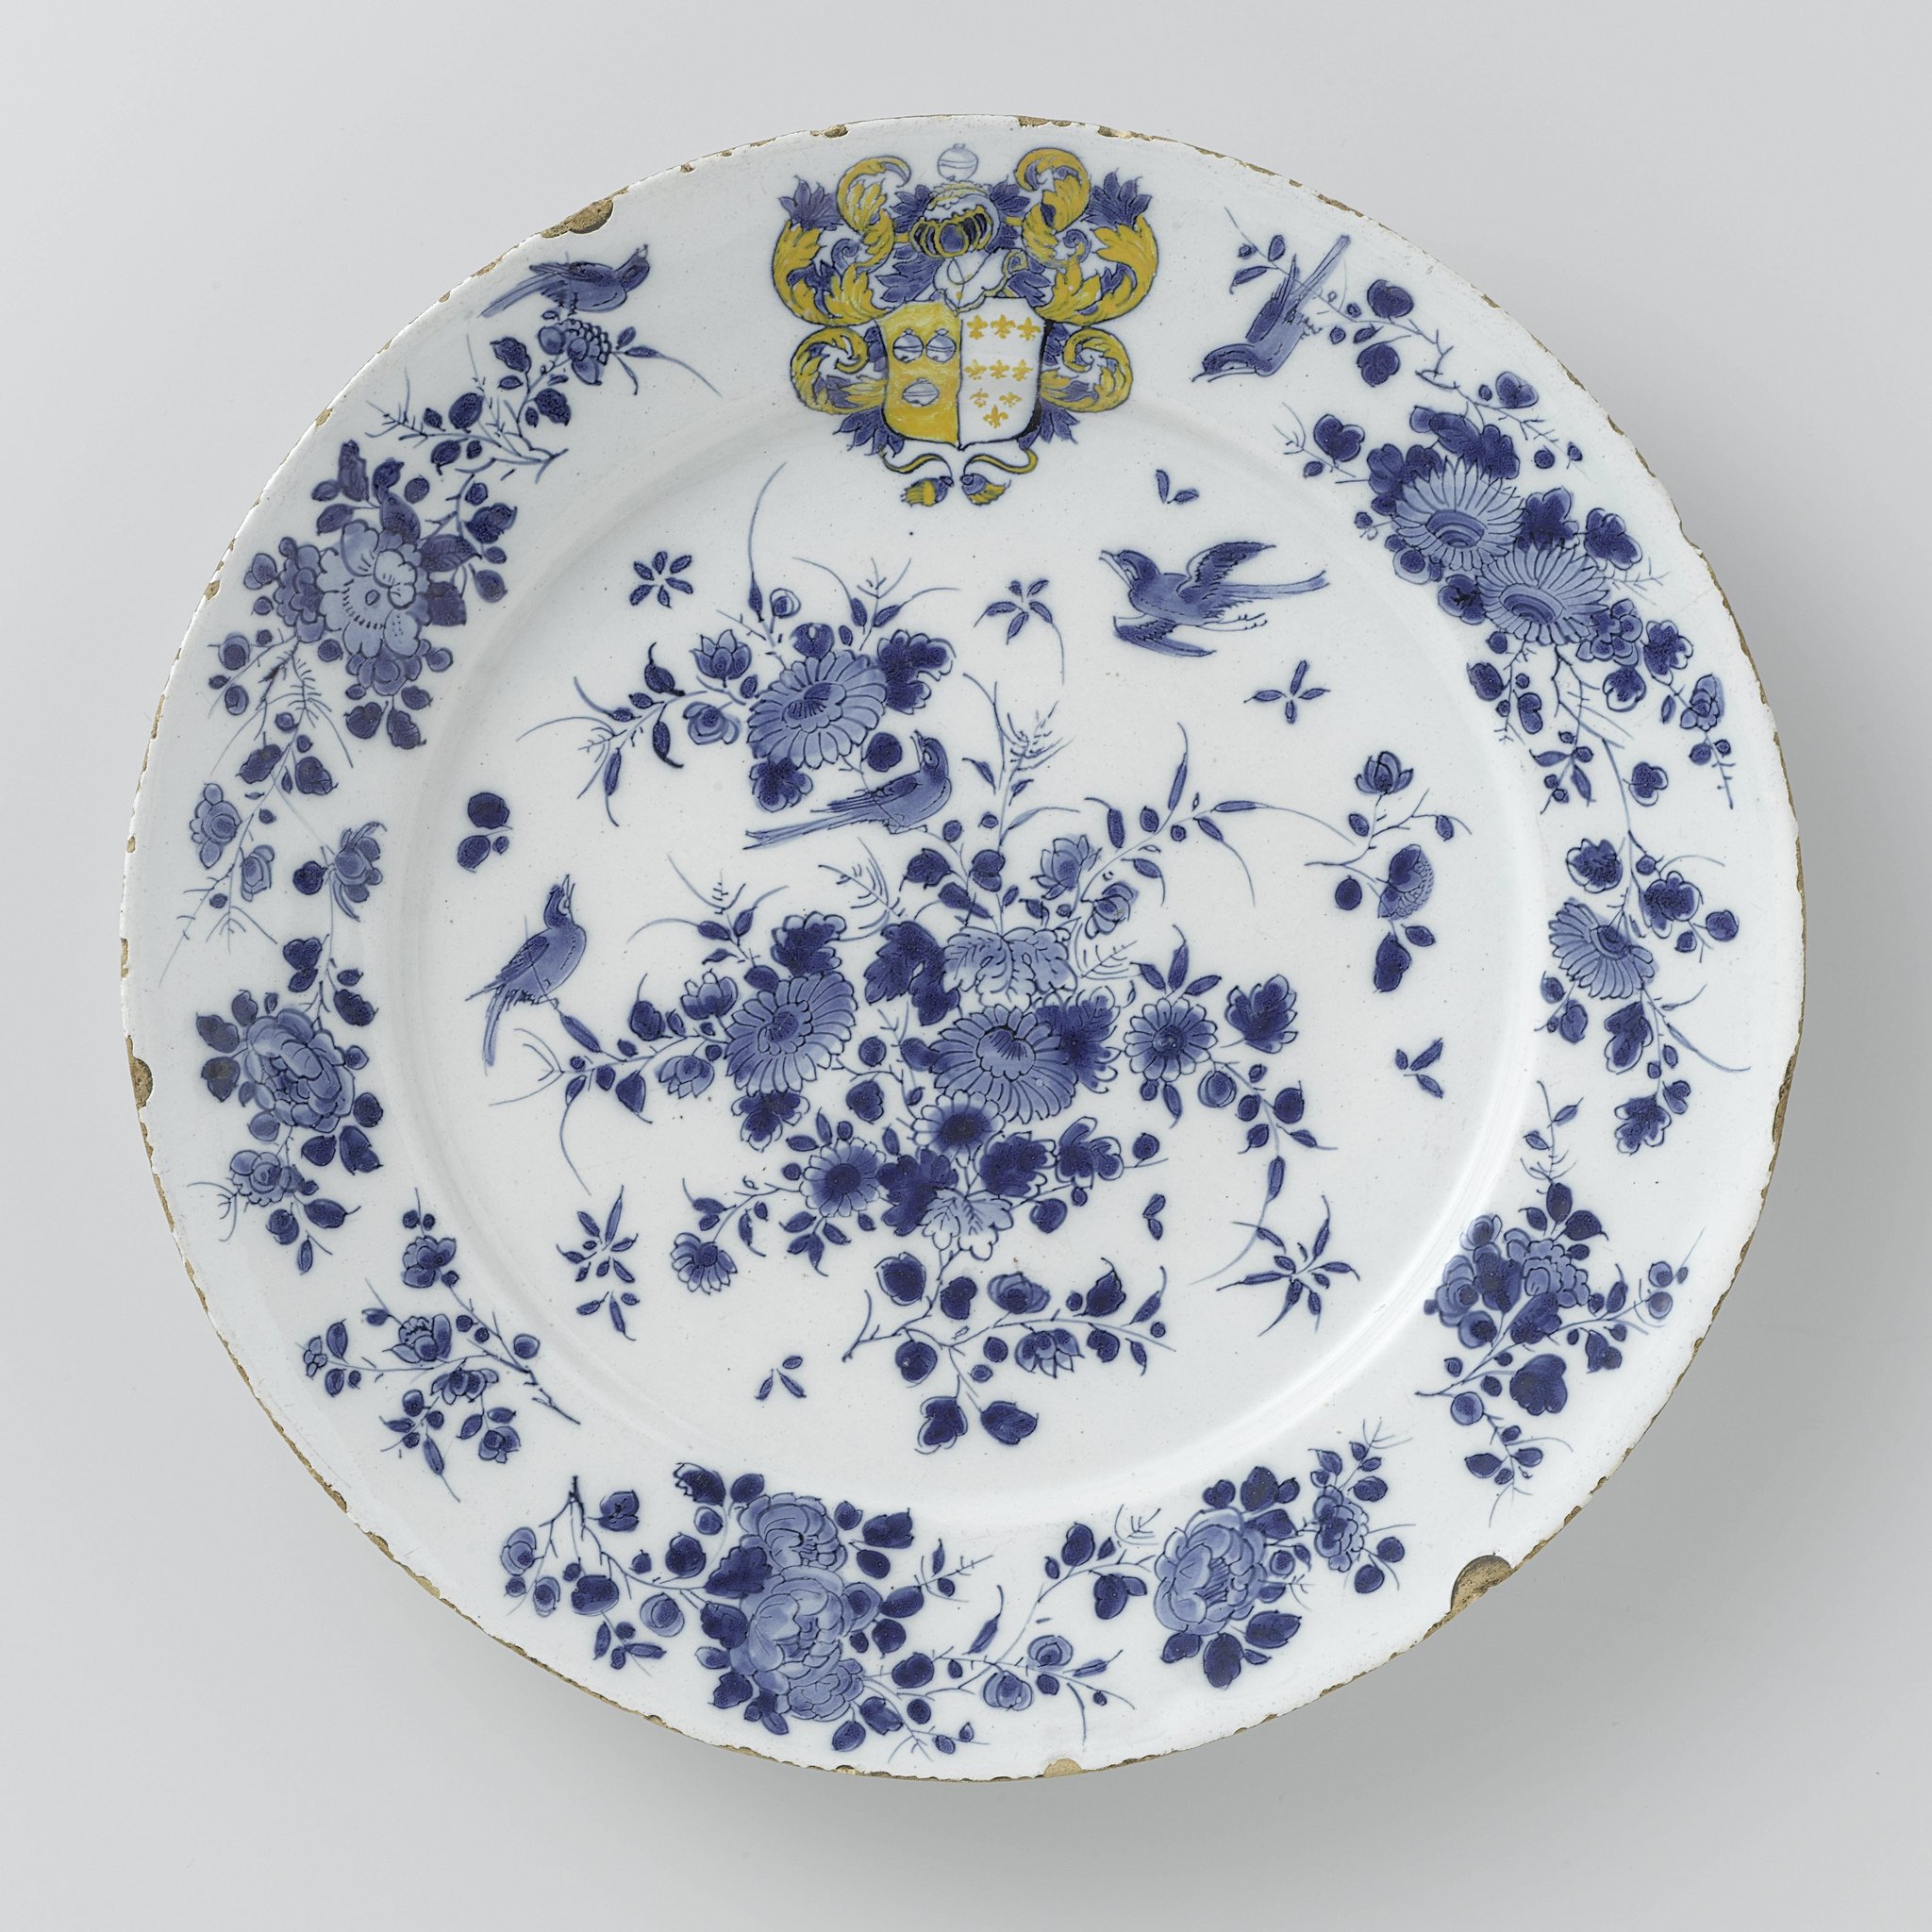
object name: plate dish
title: Bord met Chinees geïnspireerde bloemdecoraties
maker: lambertus van eenhoorn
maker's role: plateelbakker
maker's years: 1651-1721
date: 1690-1700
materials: faience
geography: delft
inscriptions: mark: ‘LVE (ineen)/ 7’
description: Bord van aardewerk, beschilderd in blauw op wit tinglazuur met bloemtakken en vogels. Op de rand en een deel van het plat een onbekend wapen met helmteken en bladwerk in blauw en geel.